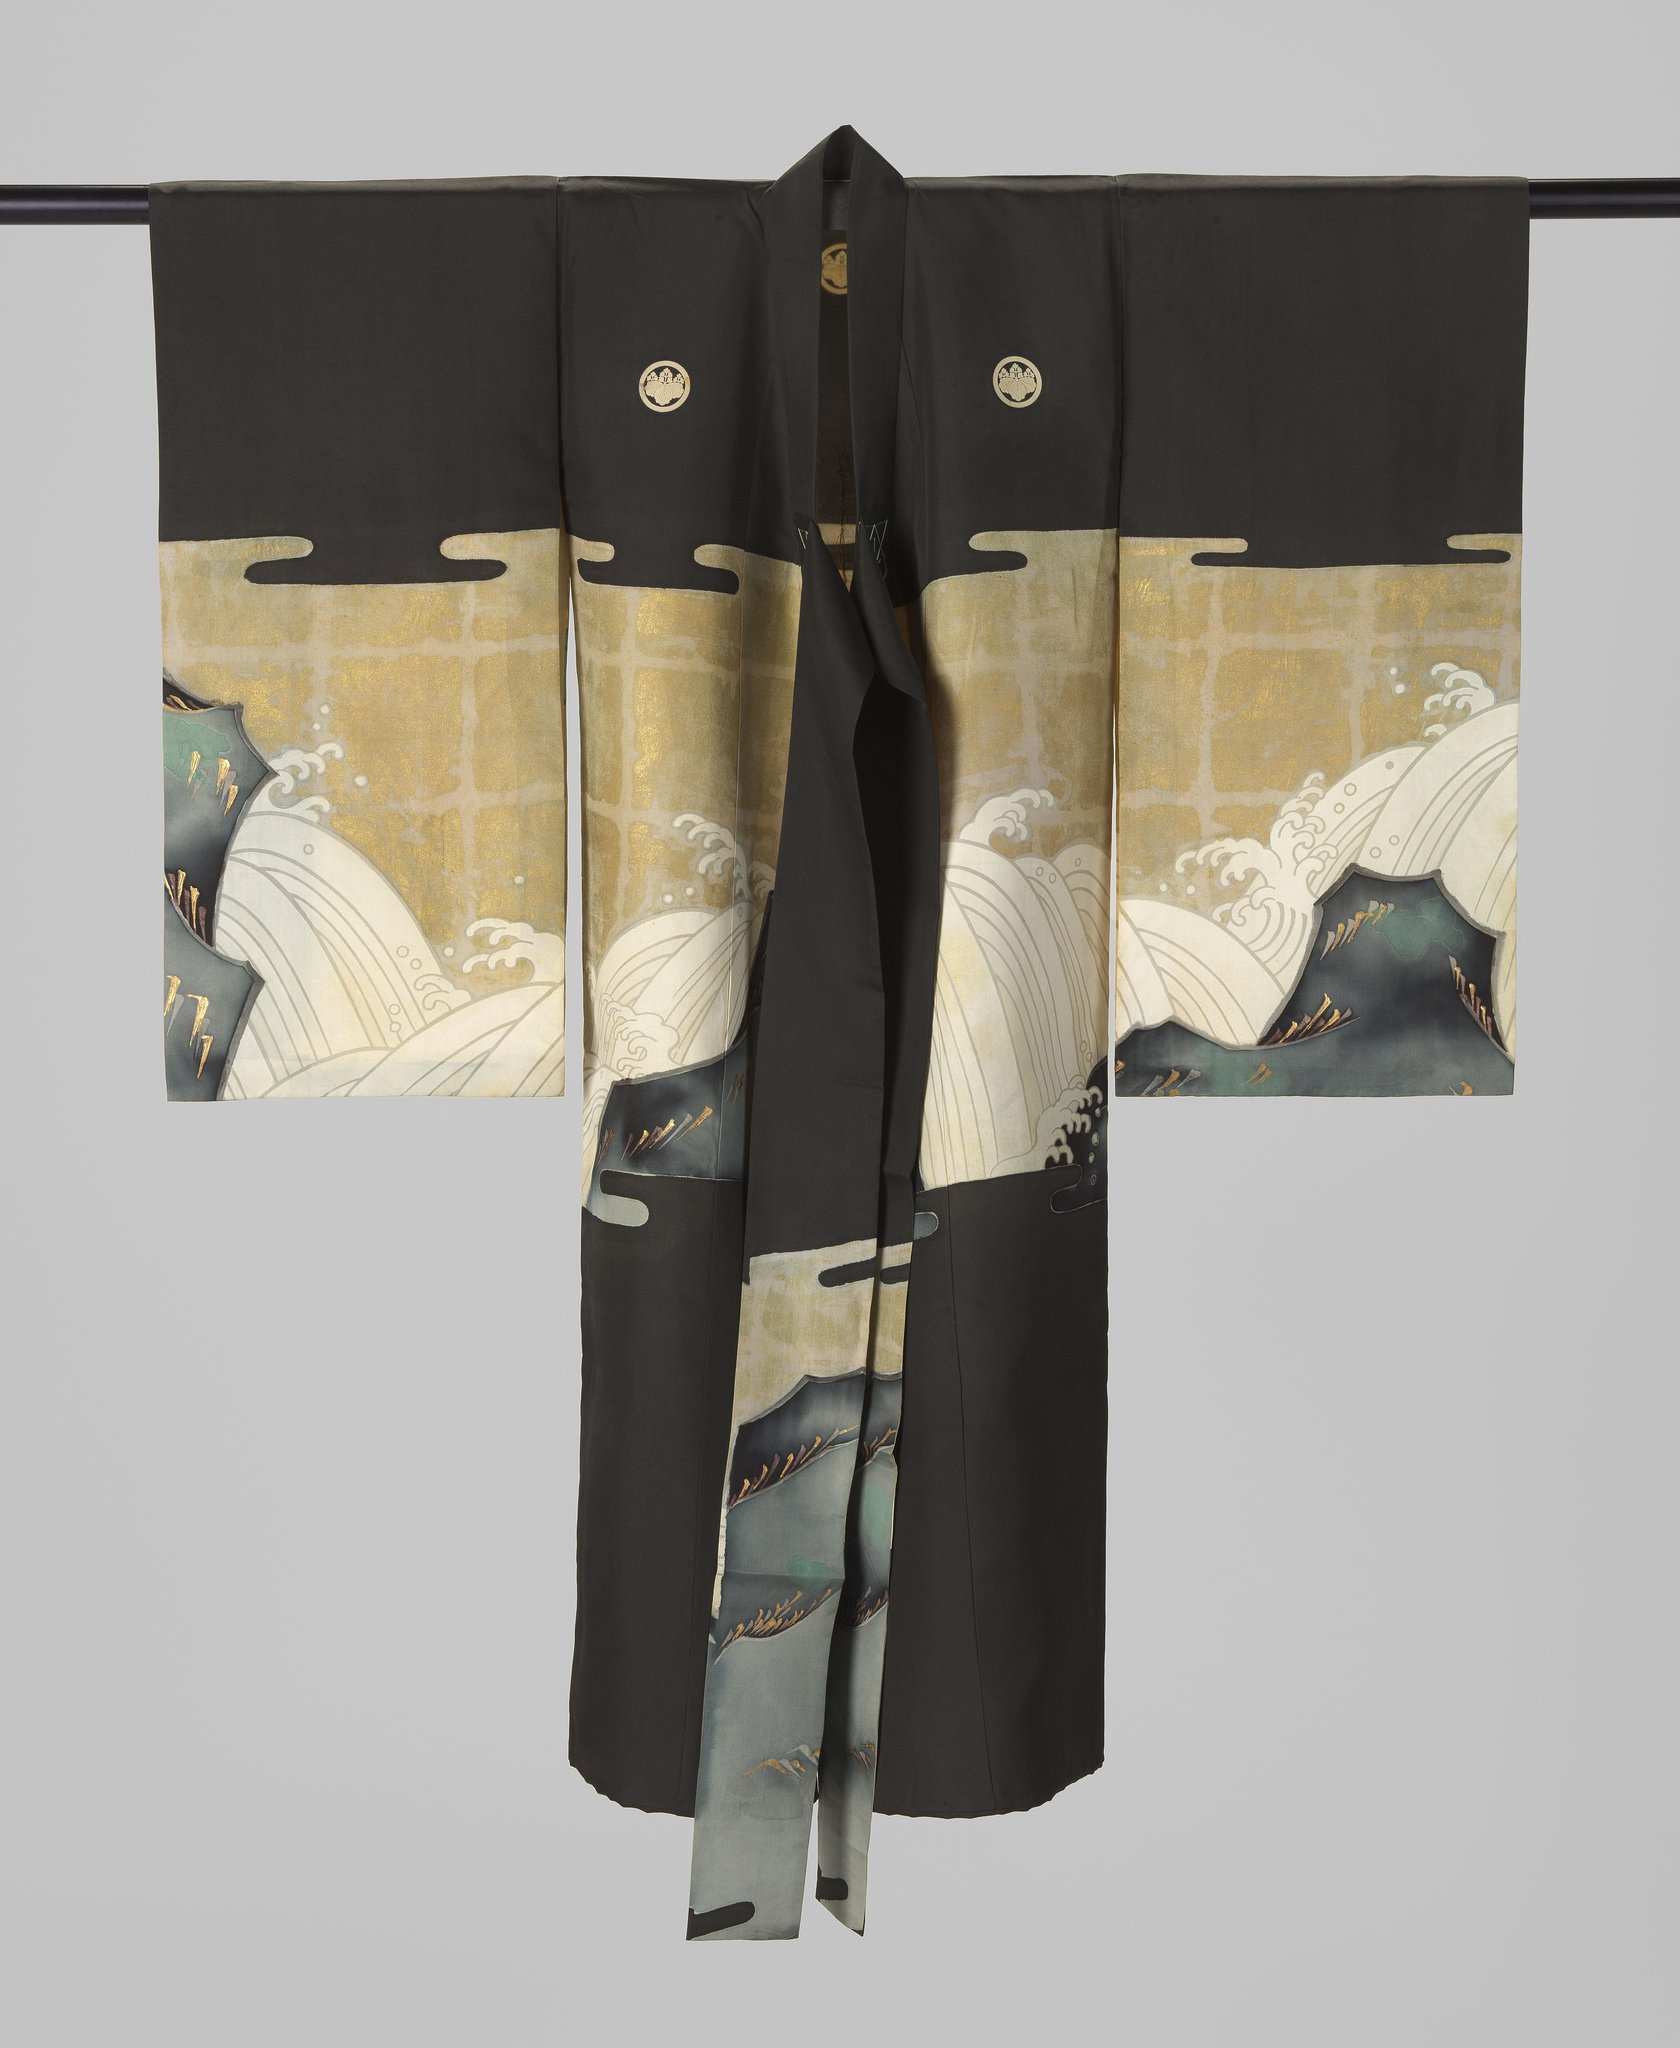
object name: kimono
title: Jongens miyamairi kimono met een Chinese leeuw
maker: Anonymous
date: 1920-1940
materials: silk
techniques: embroidered, painting, weave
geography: japan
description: Formele kimono voor een jongen voor het eerste bezoek aan een Shinto schrijn (miyamairi kimono), met een versiering van een Chinese leeuw (karashishi), de achterpoten in de lucht, de voorpoten staand op een gestileerde rotspartij met golven en wolken, tegen een achtergrond van vierkante bladen goudfolie, als van een kamerscherm. Zwarte zijde met een geschilderde yuzen decoratie in groen, wit en verschillende tinten grijs, groen en oranje, met geborduurde detaillering en goudfolie. Voering van creme zijde. Vijf familiewapens (mon) van paulownia (kiri).